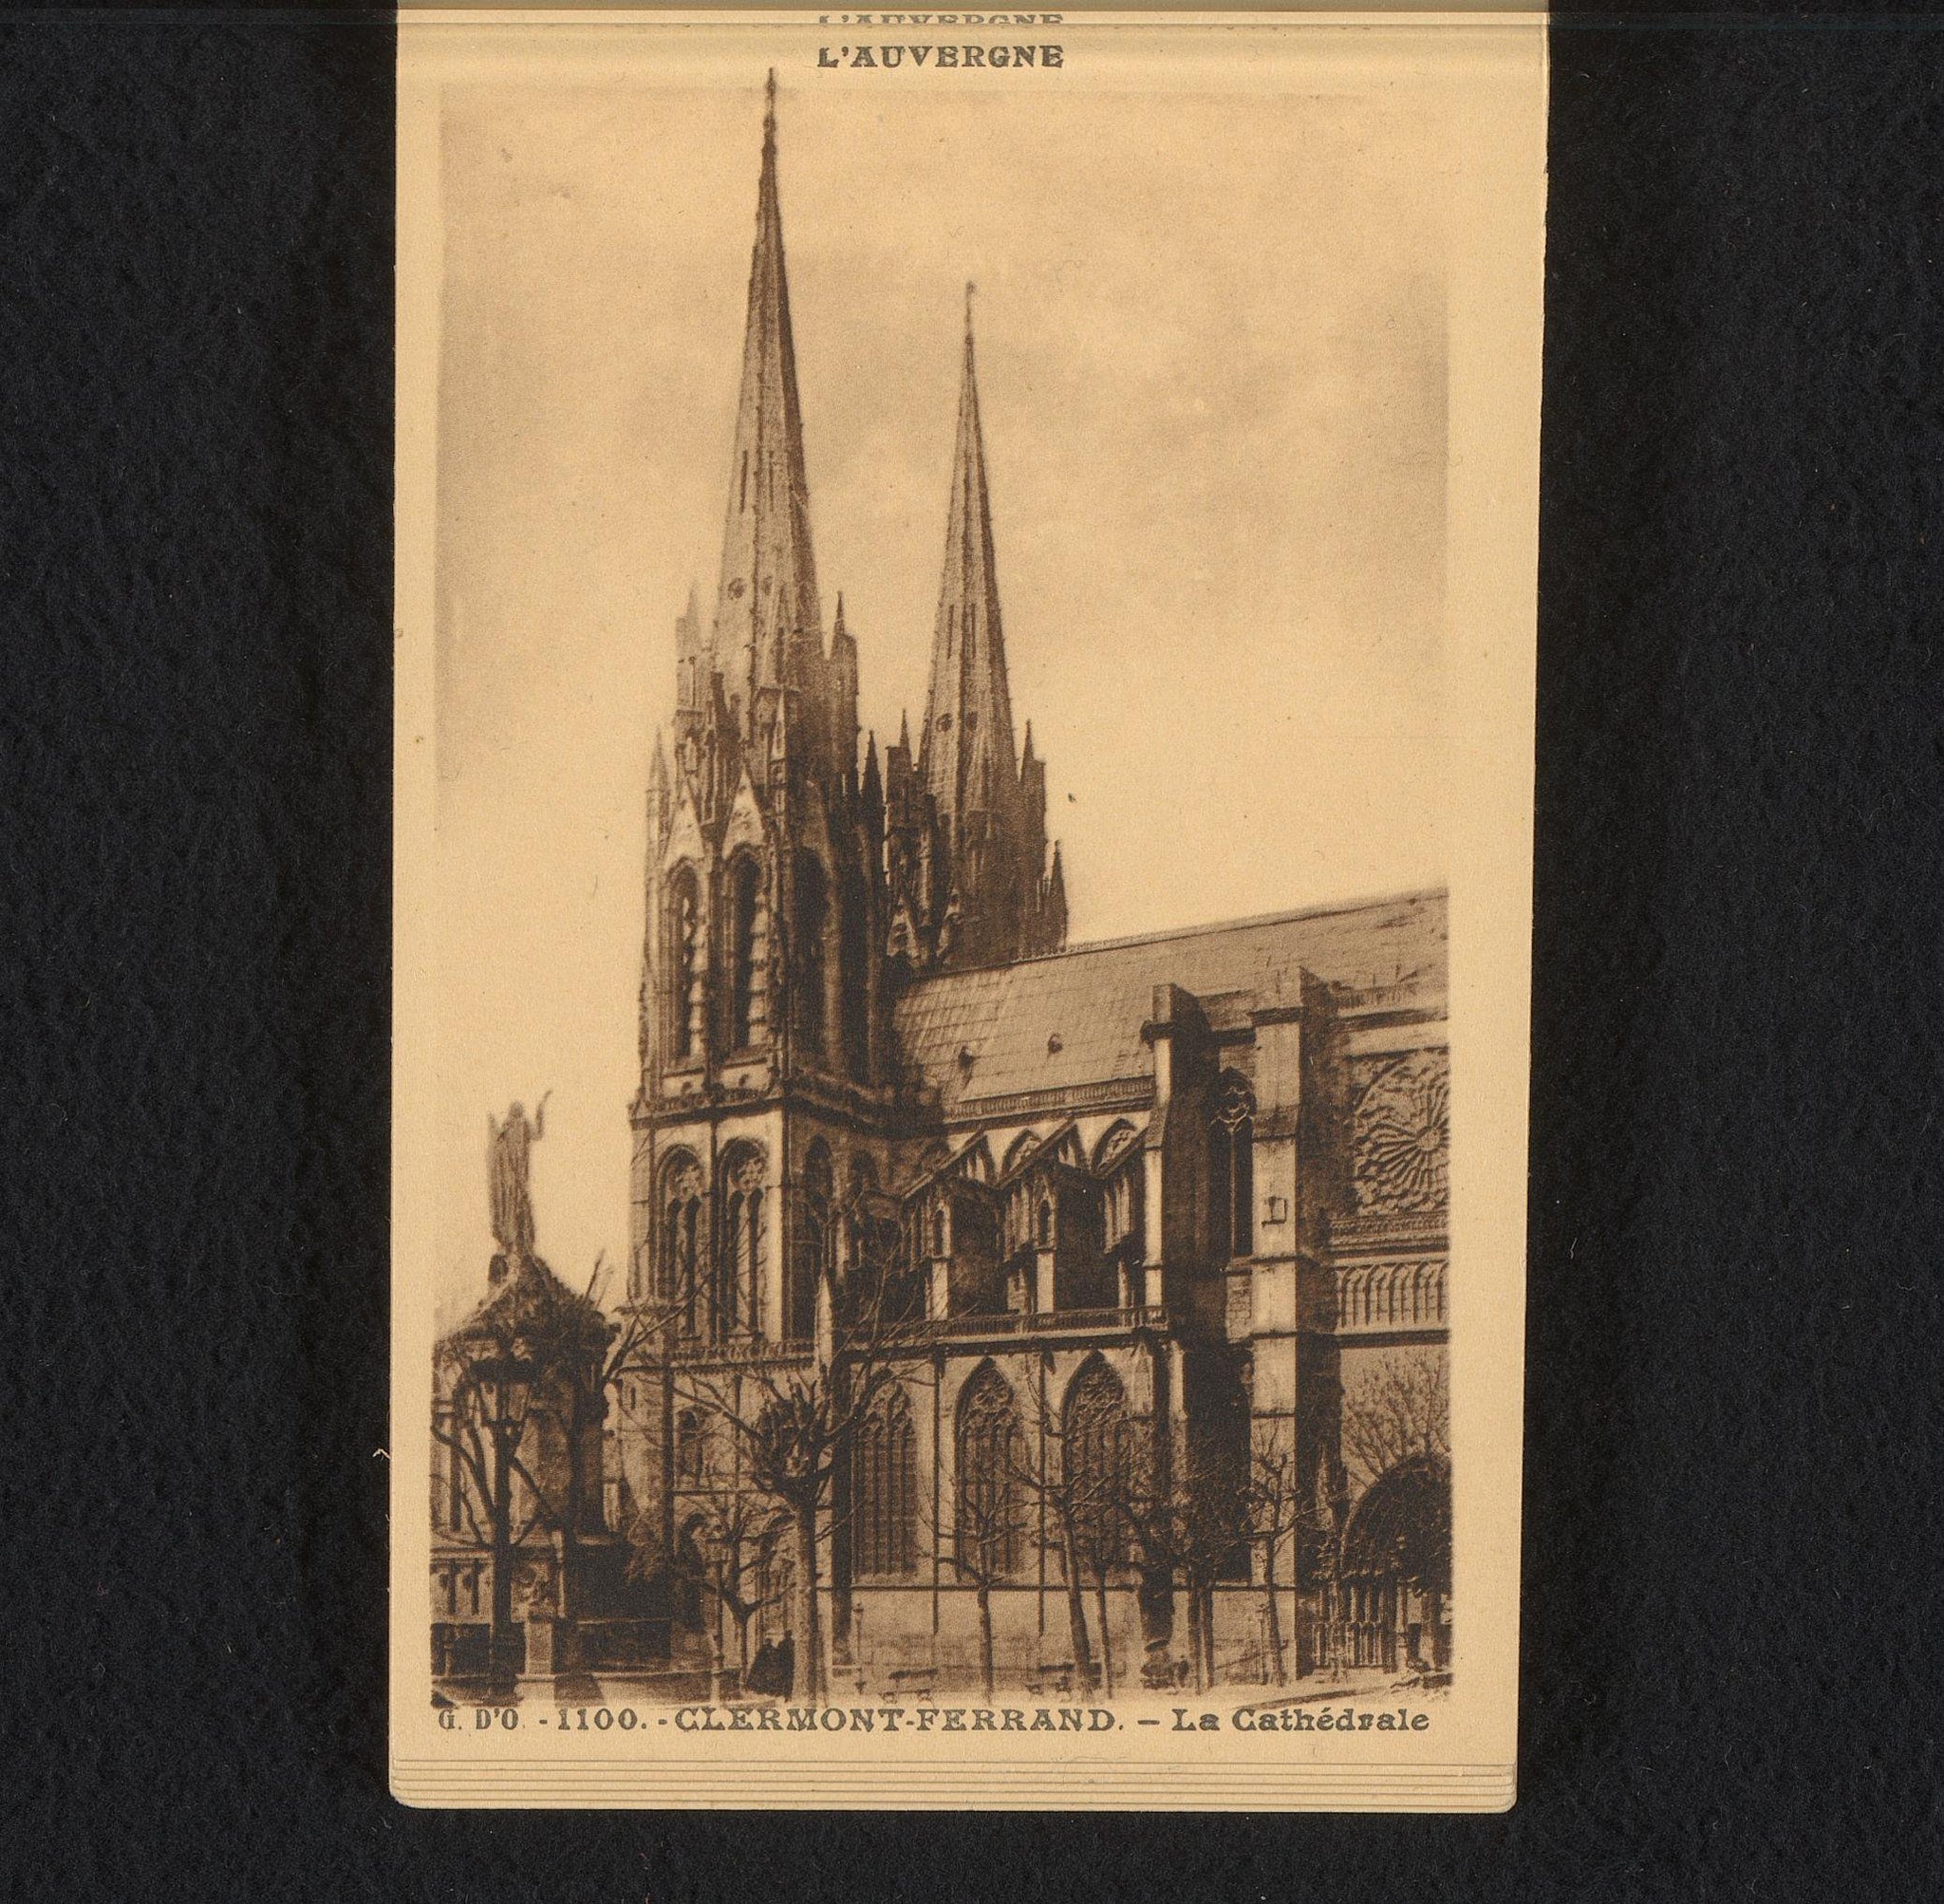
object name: photomechanical print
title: Clermont-Ferrand. La Cathédrale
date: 1921-1930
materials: cardboard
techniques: photograph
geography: clermont-ferrand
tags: church (exterior)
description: Prentbriefkaart maakt deel uit van een album.